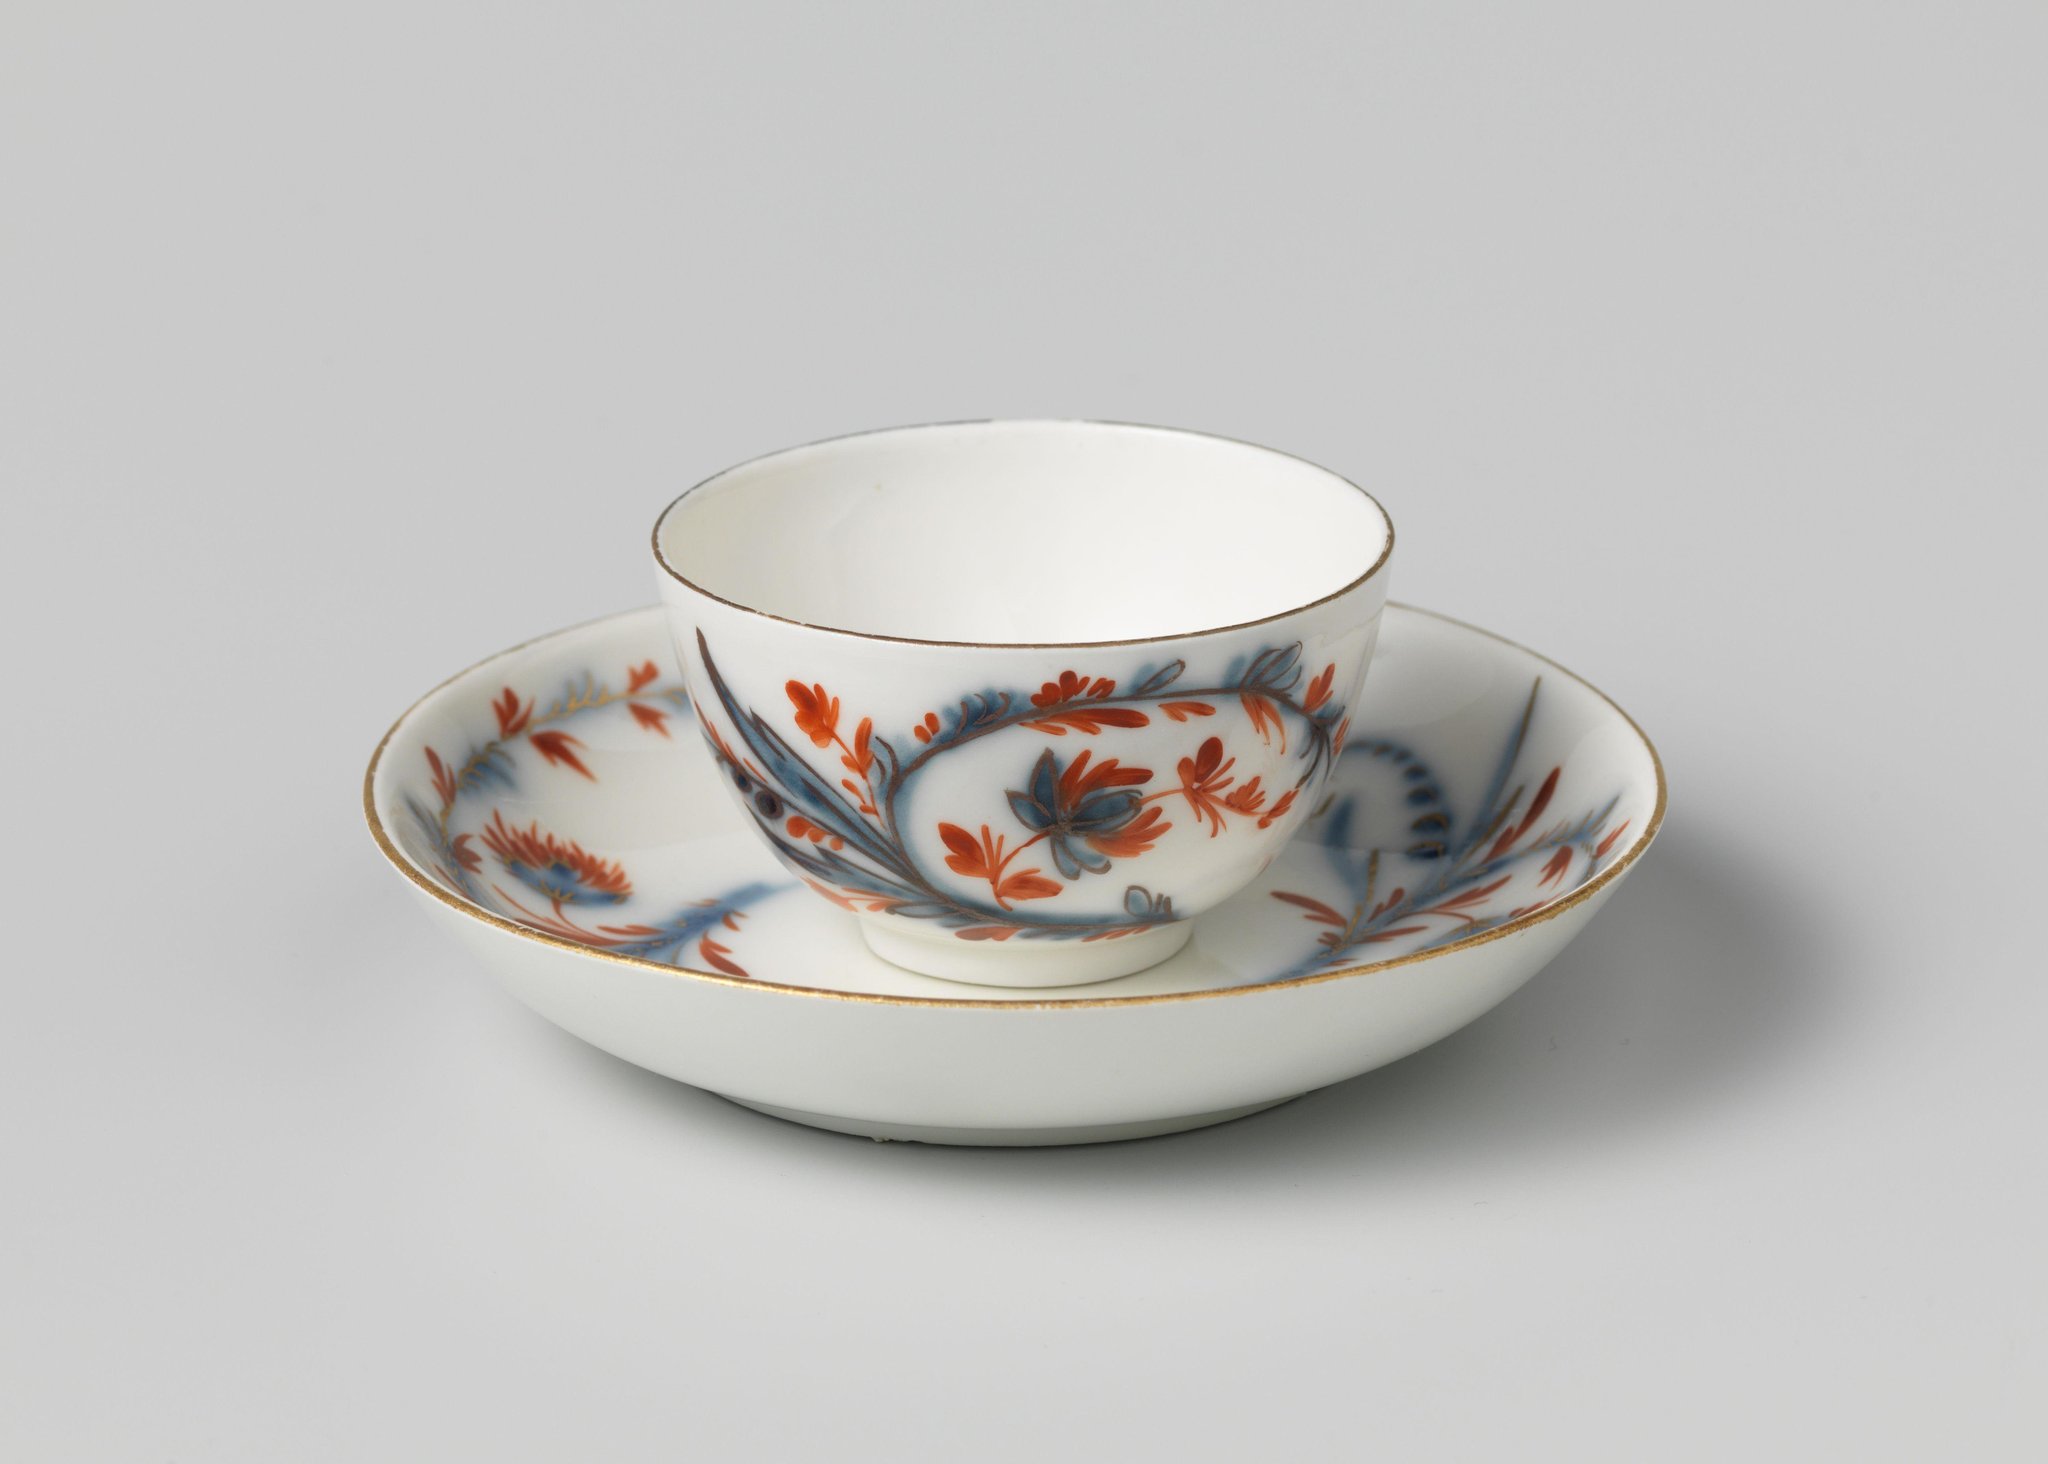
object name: cup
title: Kop, beschilderd met bloemtakken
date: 1778-1782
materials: porcelain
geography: loosdrecht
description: Kop-en-schotel van porselein. Zonder oor. Beschilderd in onderglazuurblauw, rood en goud met bloemtakken.